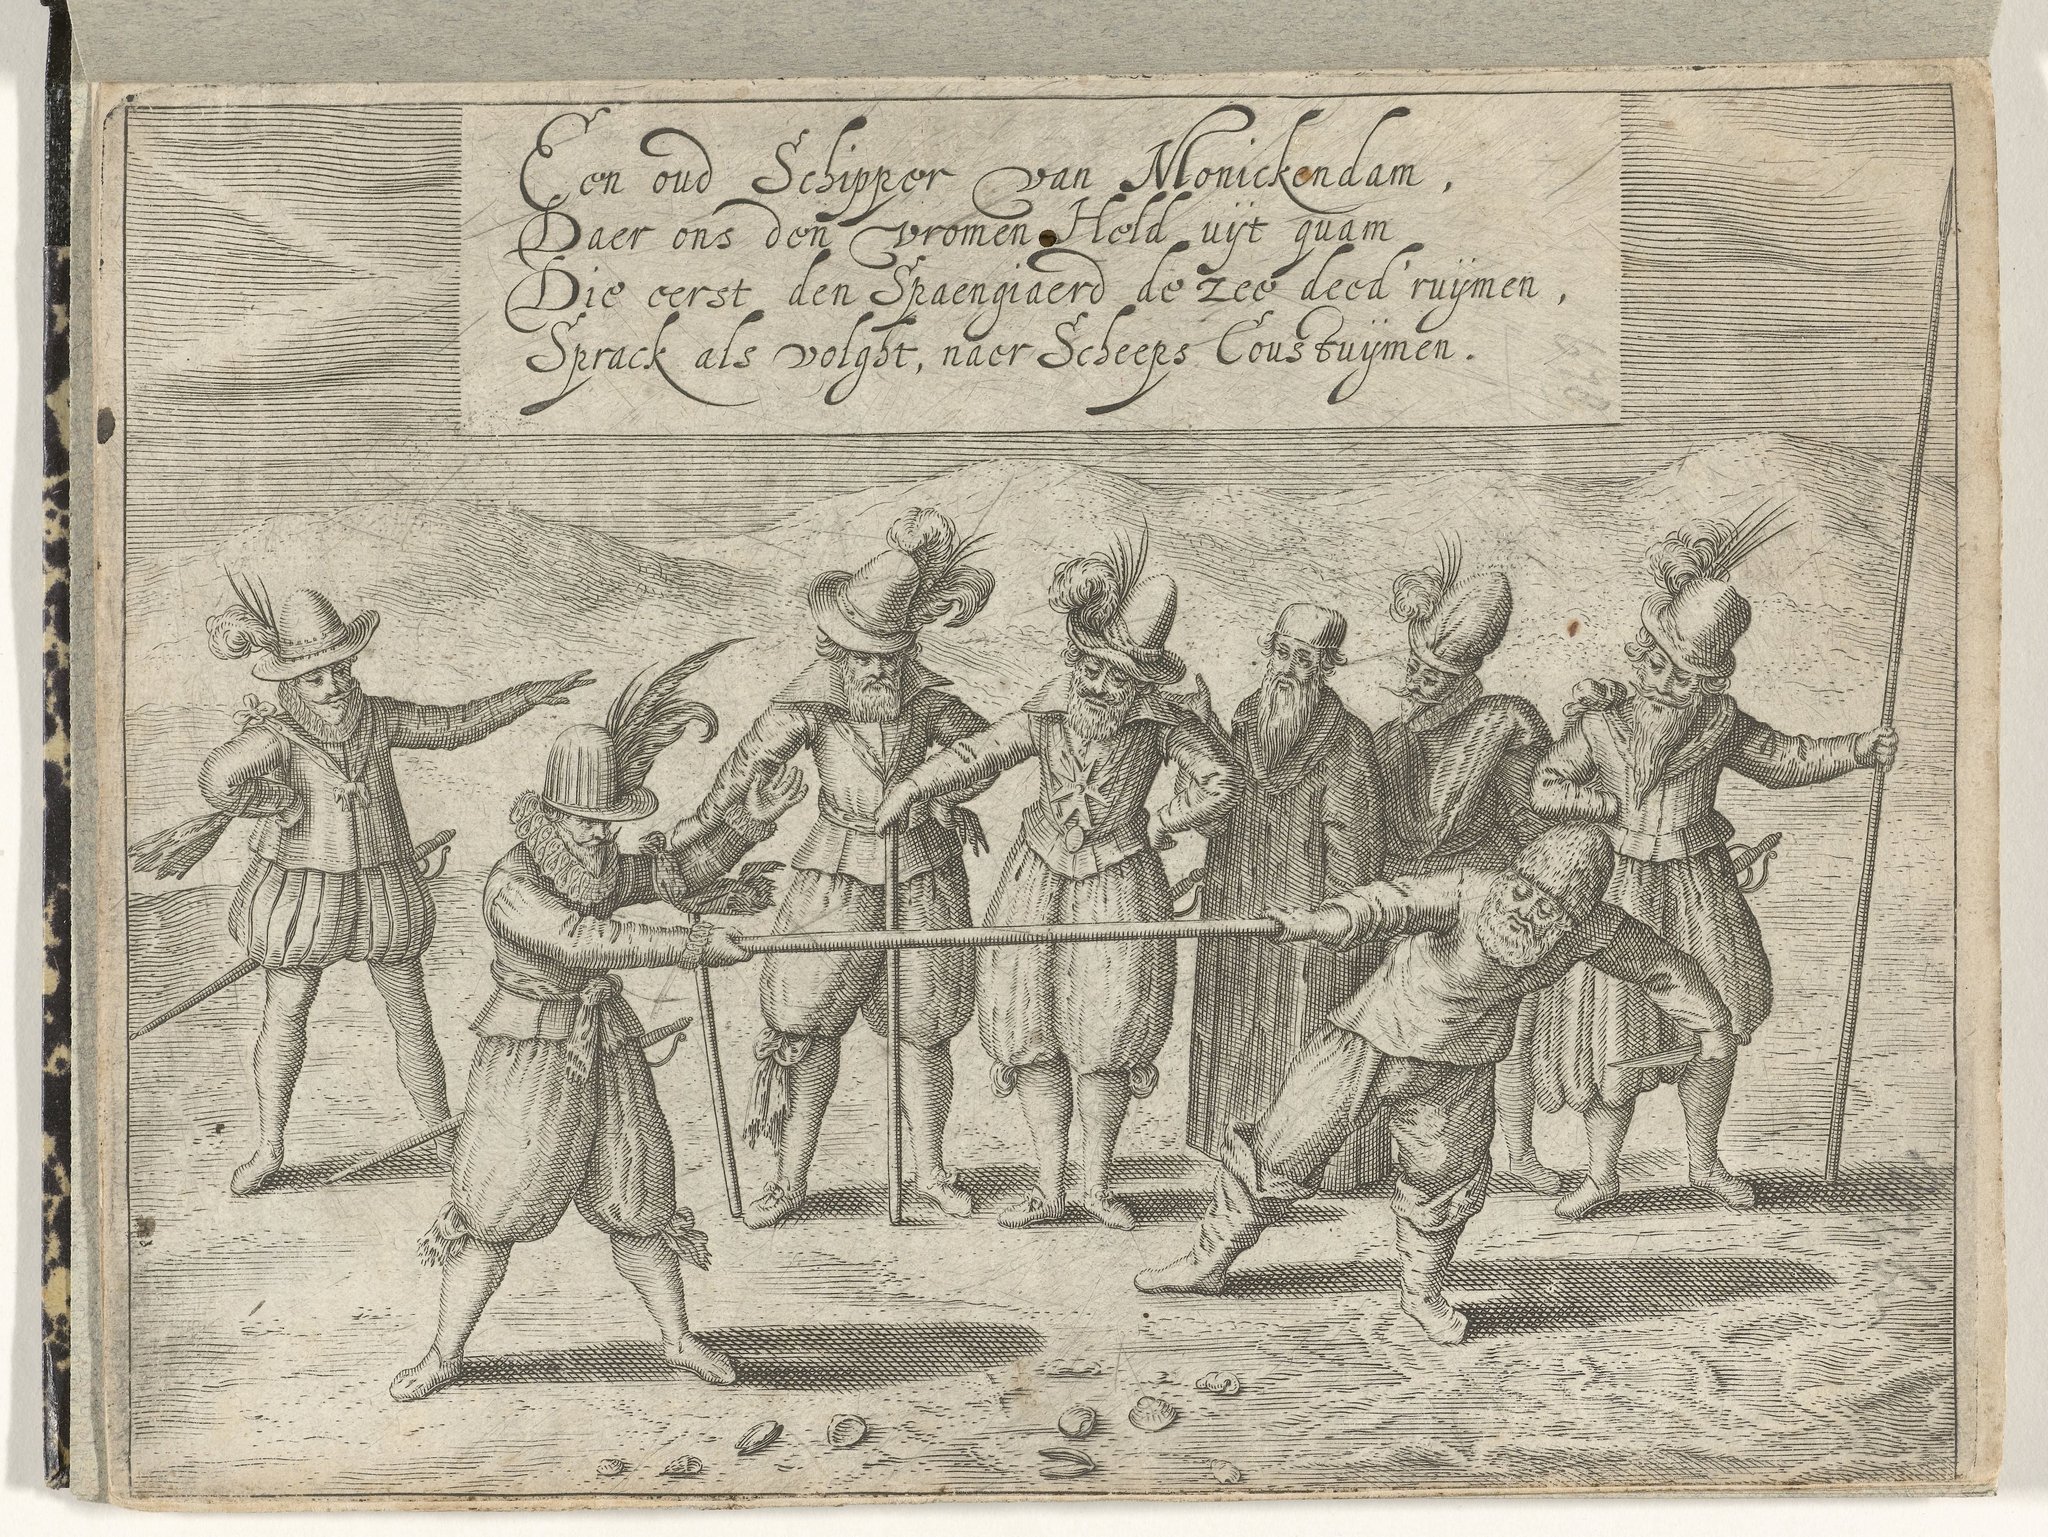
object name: pamphlet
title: De strijd om de Gouden Stok, 1608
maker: Anonymous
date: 1608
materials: paper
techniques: engraving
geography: northern netherlands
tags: the hague, maurice (prince of orange), hendrik iv (koning van frankrijk en navarra), tug-of-war, scales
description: De strijd om de Gouden Stok, 1608. Op het strand strijden een Hollandse schipper en een Spanjaard om een stok die zij beiden met een hand vasthouden. Op de achtergrond zes toeschouwers, waaronder prins Maurits (links) en koning Hendrik IV van Frankrijk (midden). De trekwedstrijd verbeeldt de strijd tussen de Republiek en Spanje om de macht in Oost-Indië en West-Indië, de gouden stok die rijkdommen schenkt. Bovenin de voorstelling in een cartouche een vers van 4 regels in het Nederlands: Een oud Schipper van Monickendam etc. Prent voorin een pamflet tegen de vredesonderhandelingen voor het Bestand in het jaar 1608.